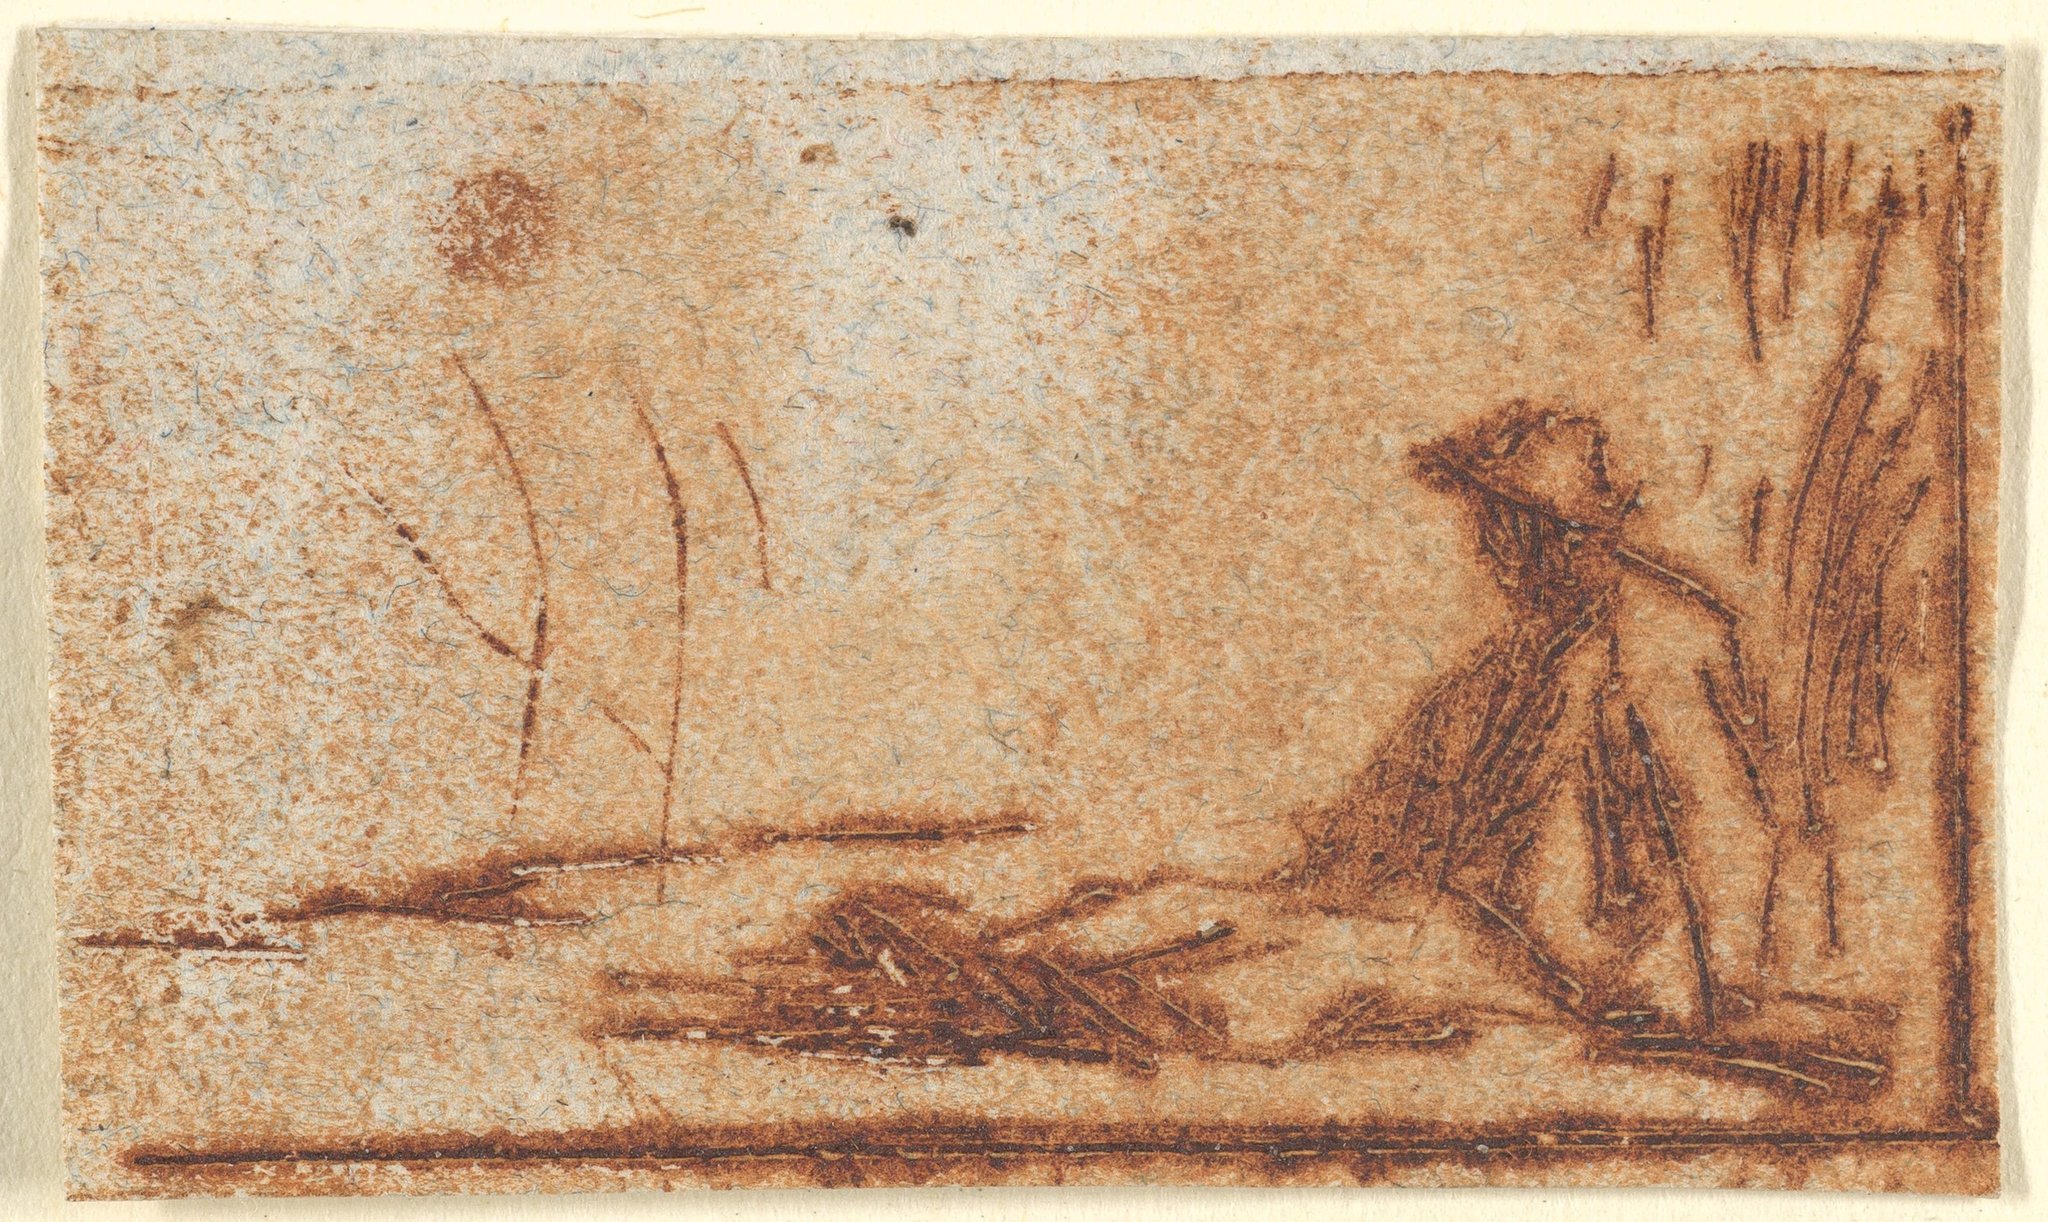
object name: print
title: Seated Peasant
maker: jean-françois millet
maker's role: artist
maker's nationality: french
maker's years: 1814-1875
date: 1830-1875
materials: ink, paper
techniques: etching, printing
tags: human figures